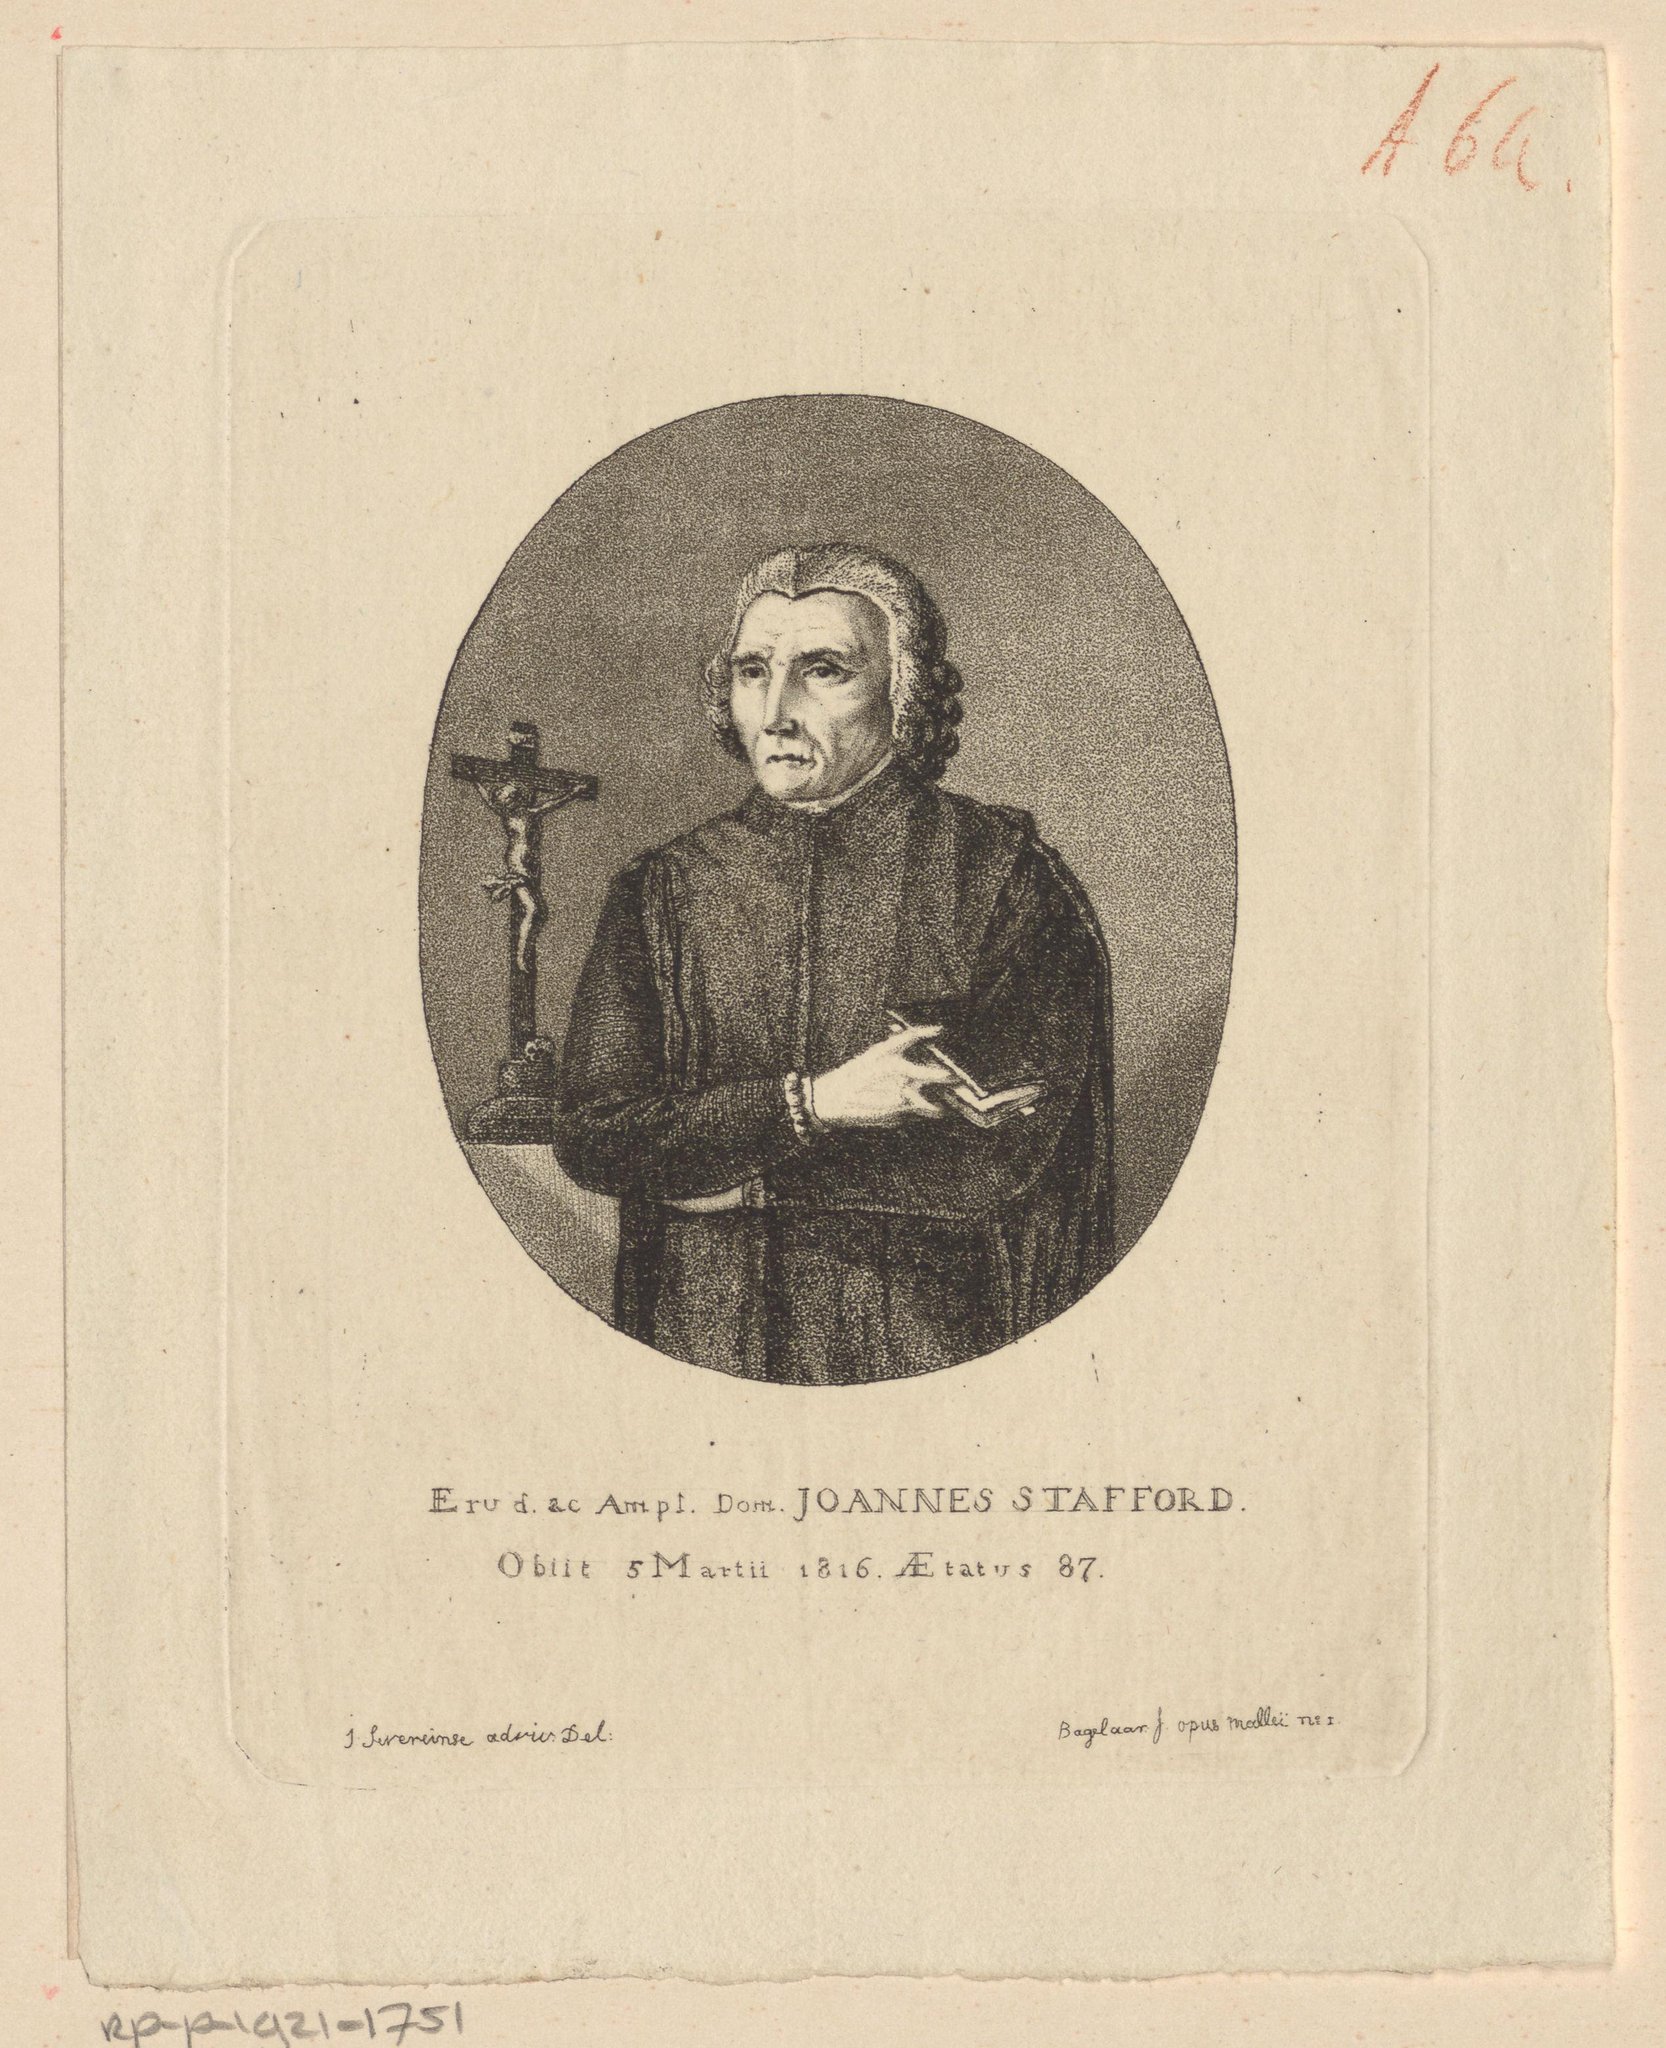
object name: print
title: Portret van Joannes Stafford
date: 1816-1837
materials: paper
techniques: etching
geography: netherlands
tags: historical persons, functionaries and dignitaries (with name) ~ episcopal protestant churches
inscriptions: collector's mark: Lugt 2233, number: ‘A 64.’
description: Met tweeregelig onderschrift in het Latijn.